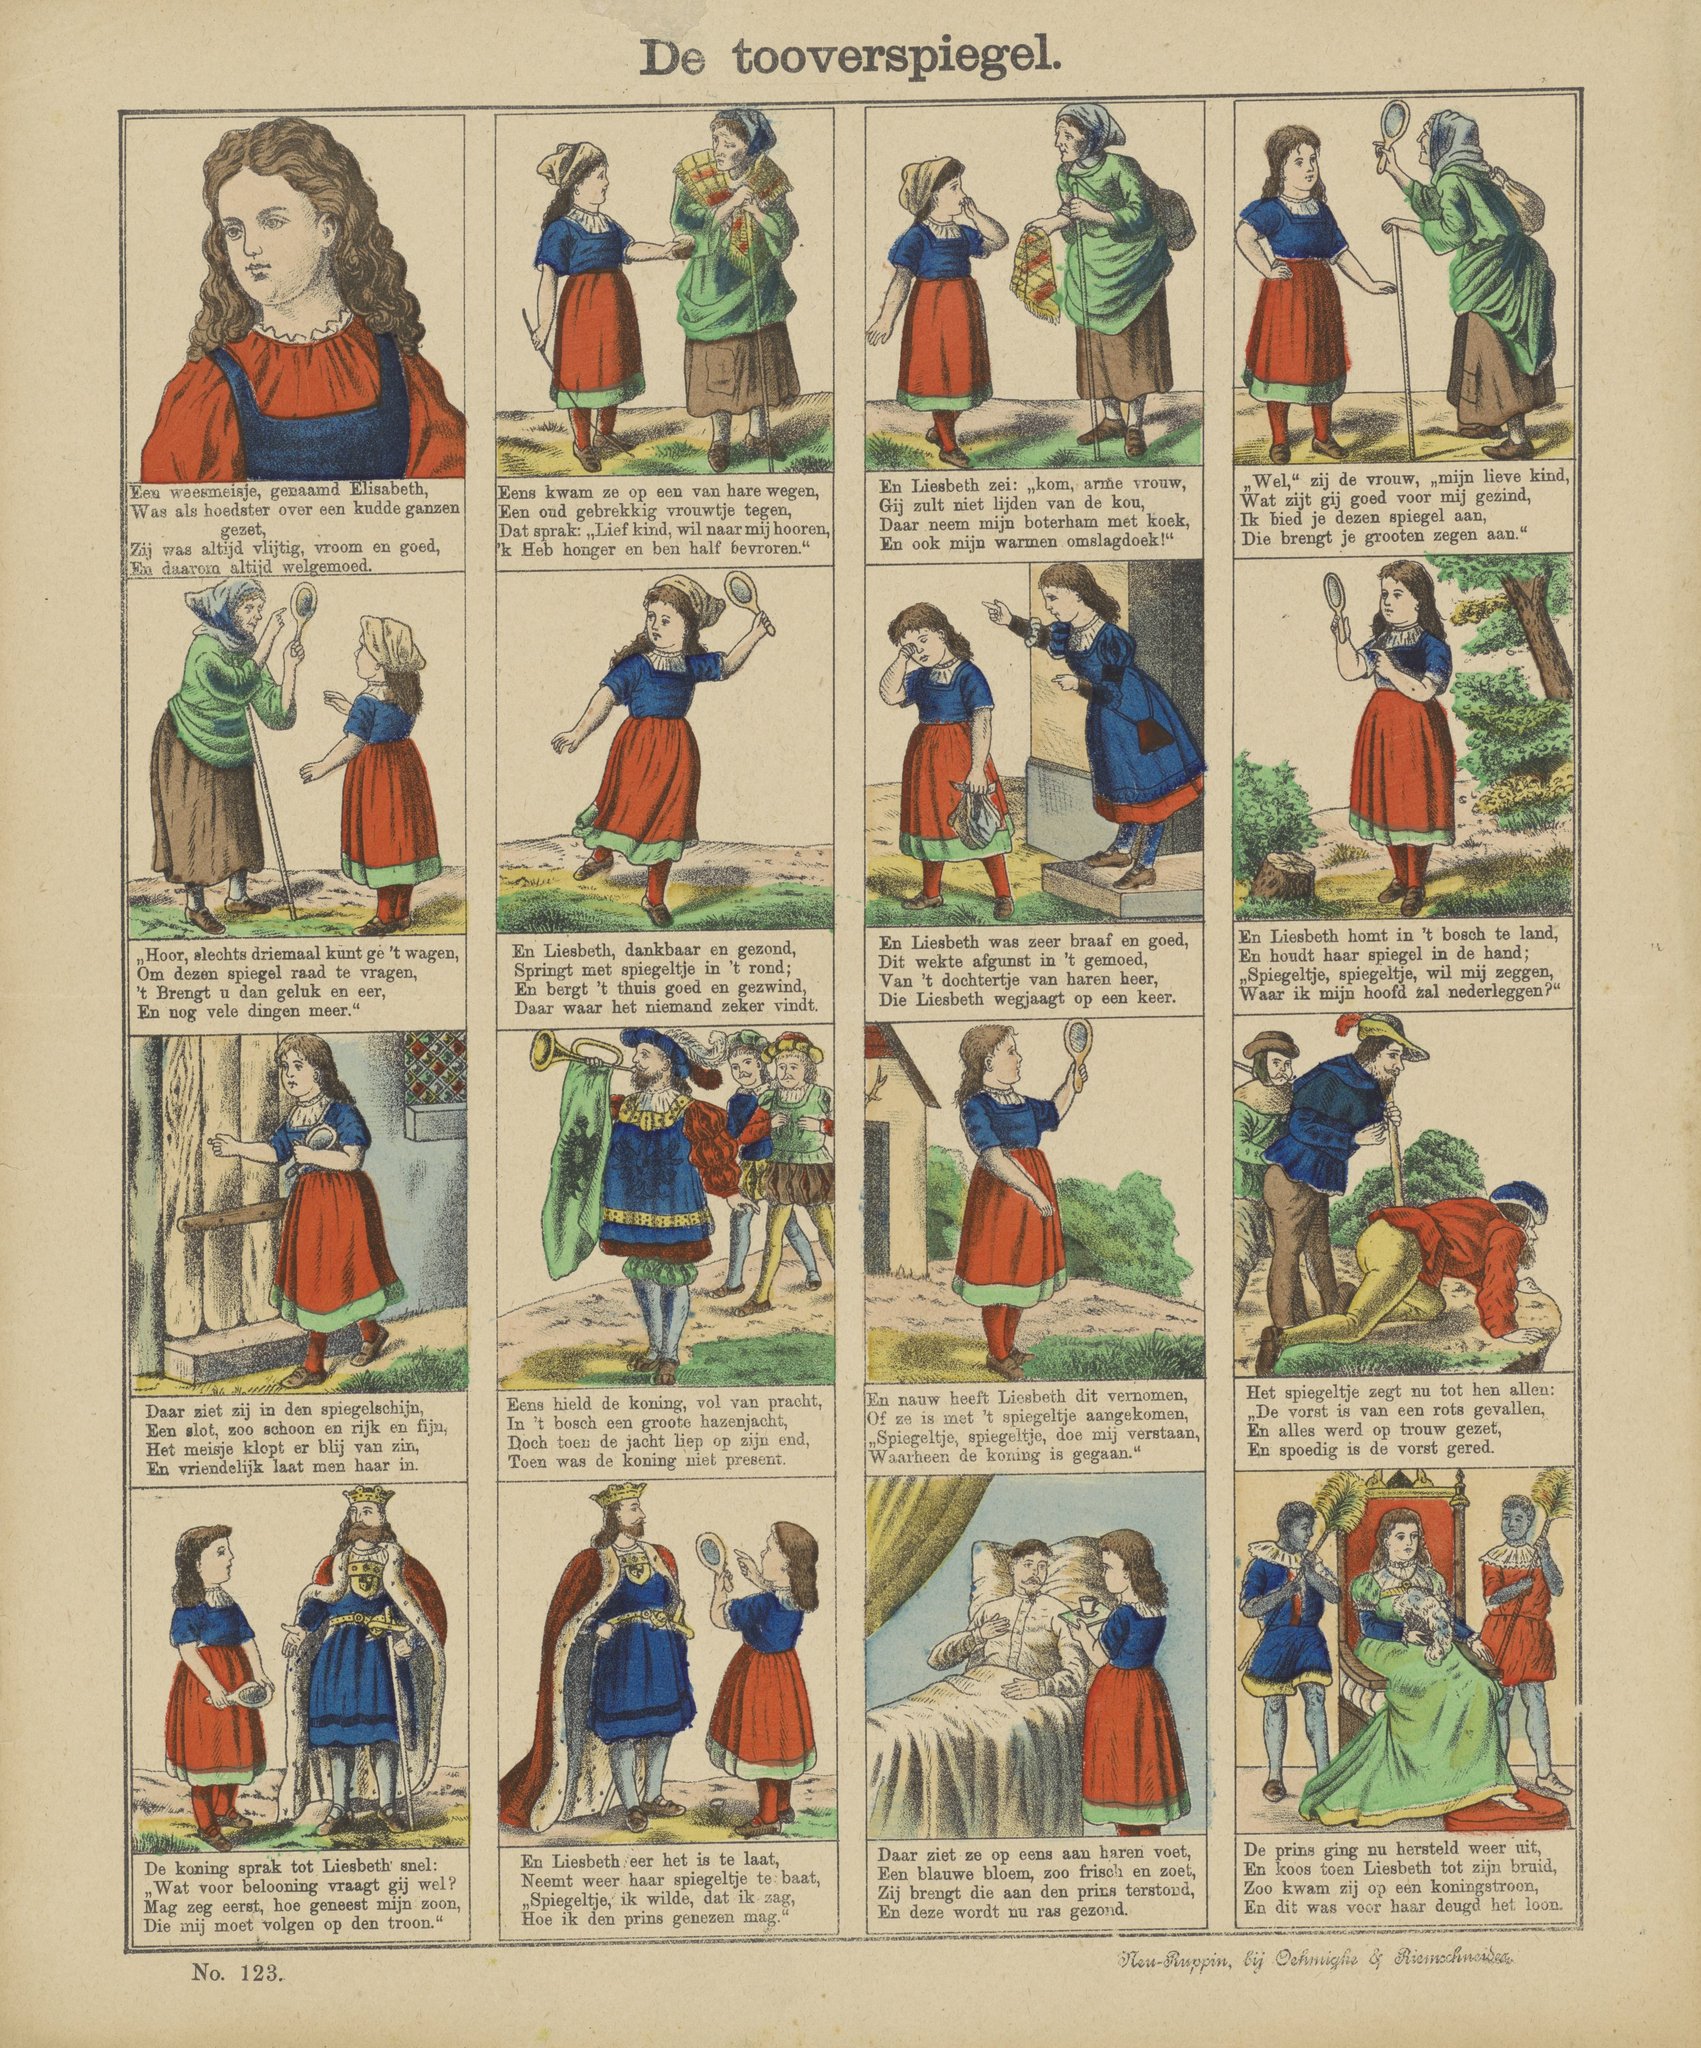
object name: print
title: De tooverspiegel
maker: Anonymous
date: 1828-1937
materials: paper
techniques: hand coloring, letterpress printing, lithograph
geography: neuruppin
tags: magic, supernaturalism, occultism, mirror, princess, tales and fairy tales, orphans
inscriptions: collector's mark: Lugt 2760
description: Blad met 16 voorstellingen uit het verhaal van de toverspiegel, over een weesmeisje dat met behulp van een toverspiegel een prinses wordt. Onder elke afbeelding een onderschrift. Genummerd linksonder: No. 123.